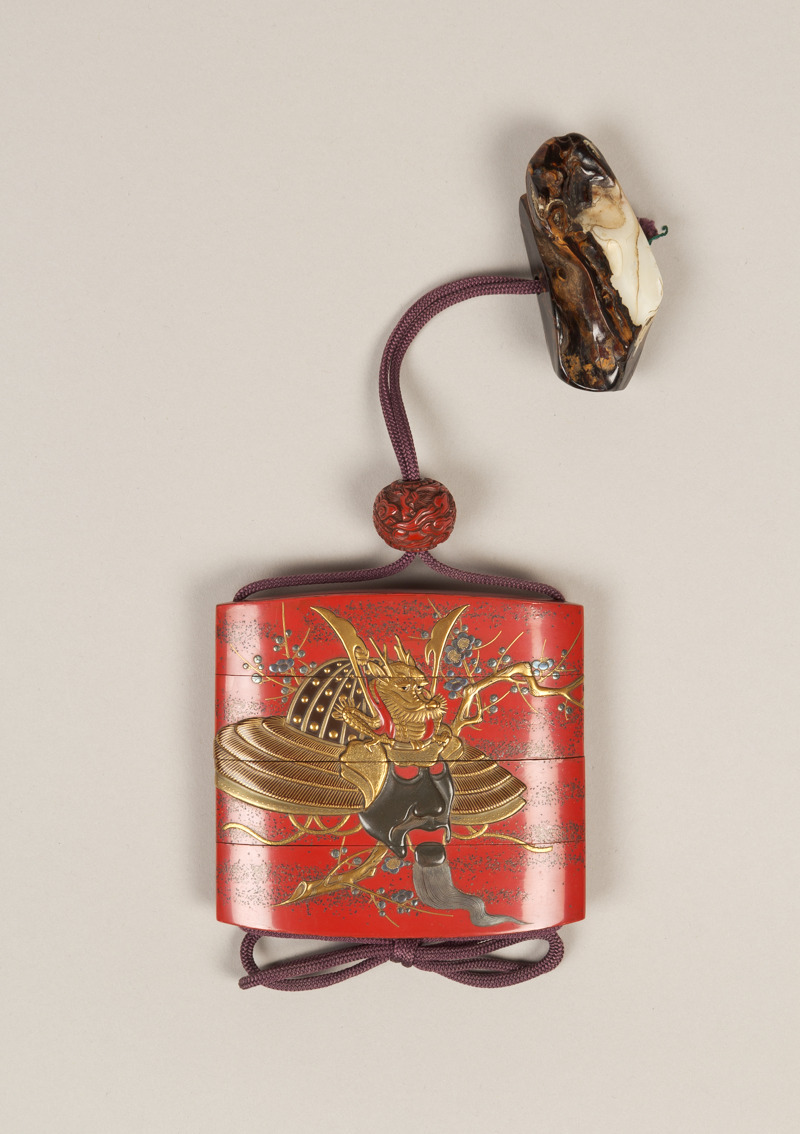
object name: inrō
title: Inrō with the Noh Play Ebira (Quiver)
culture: japanese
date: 1801-1850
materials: gold, lacquer, silver, wood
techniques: carving, hiramakie, lacquer, maki-e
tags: arrows,helmets,swords